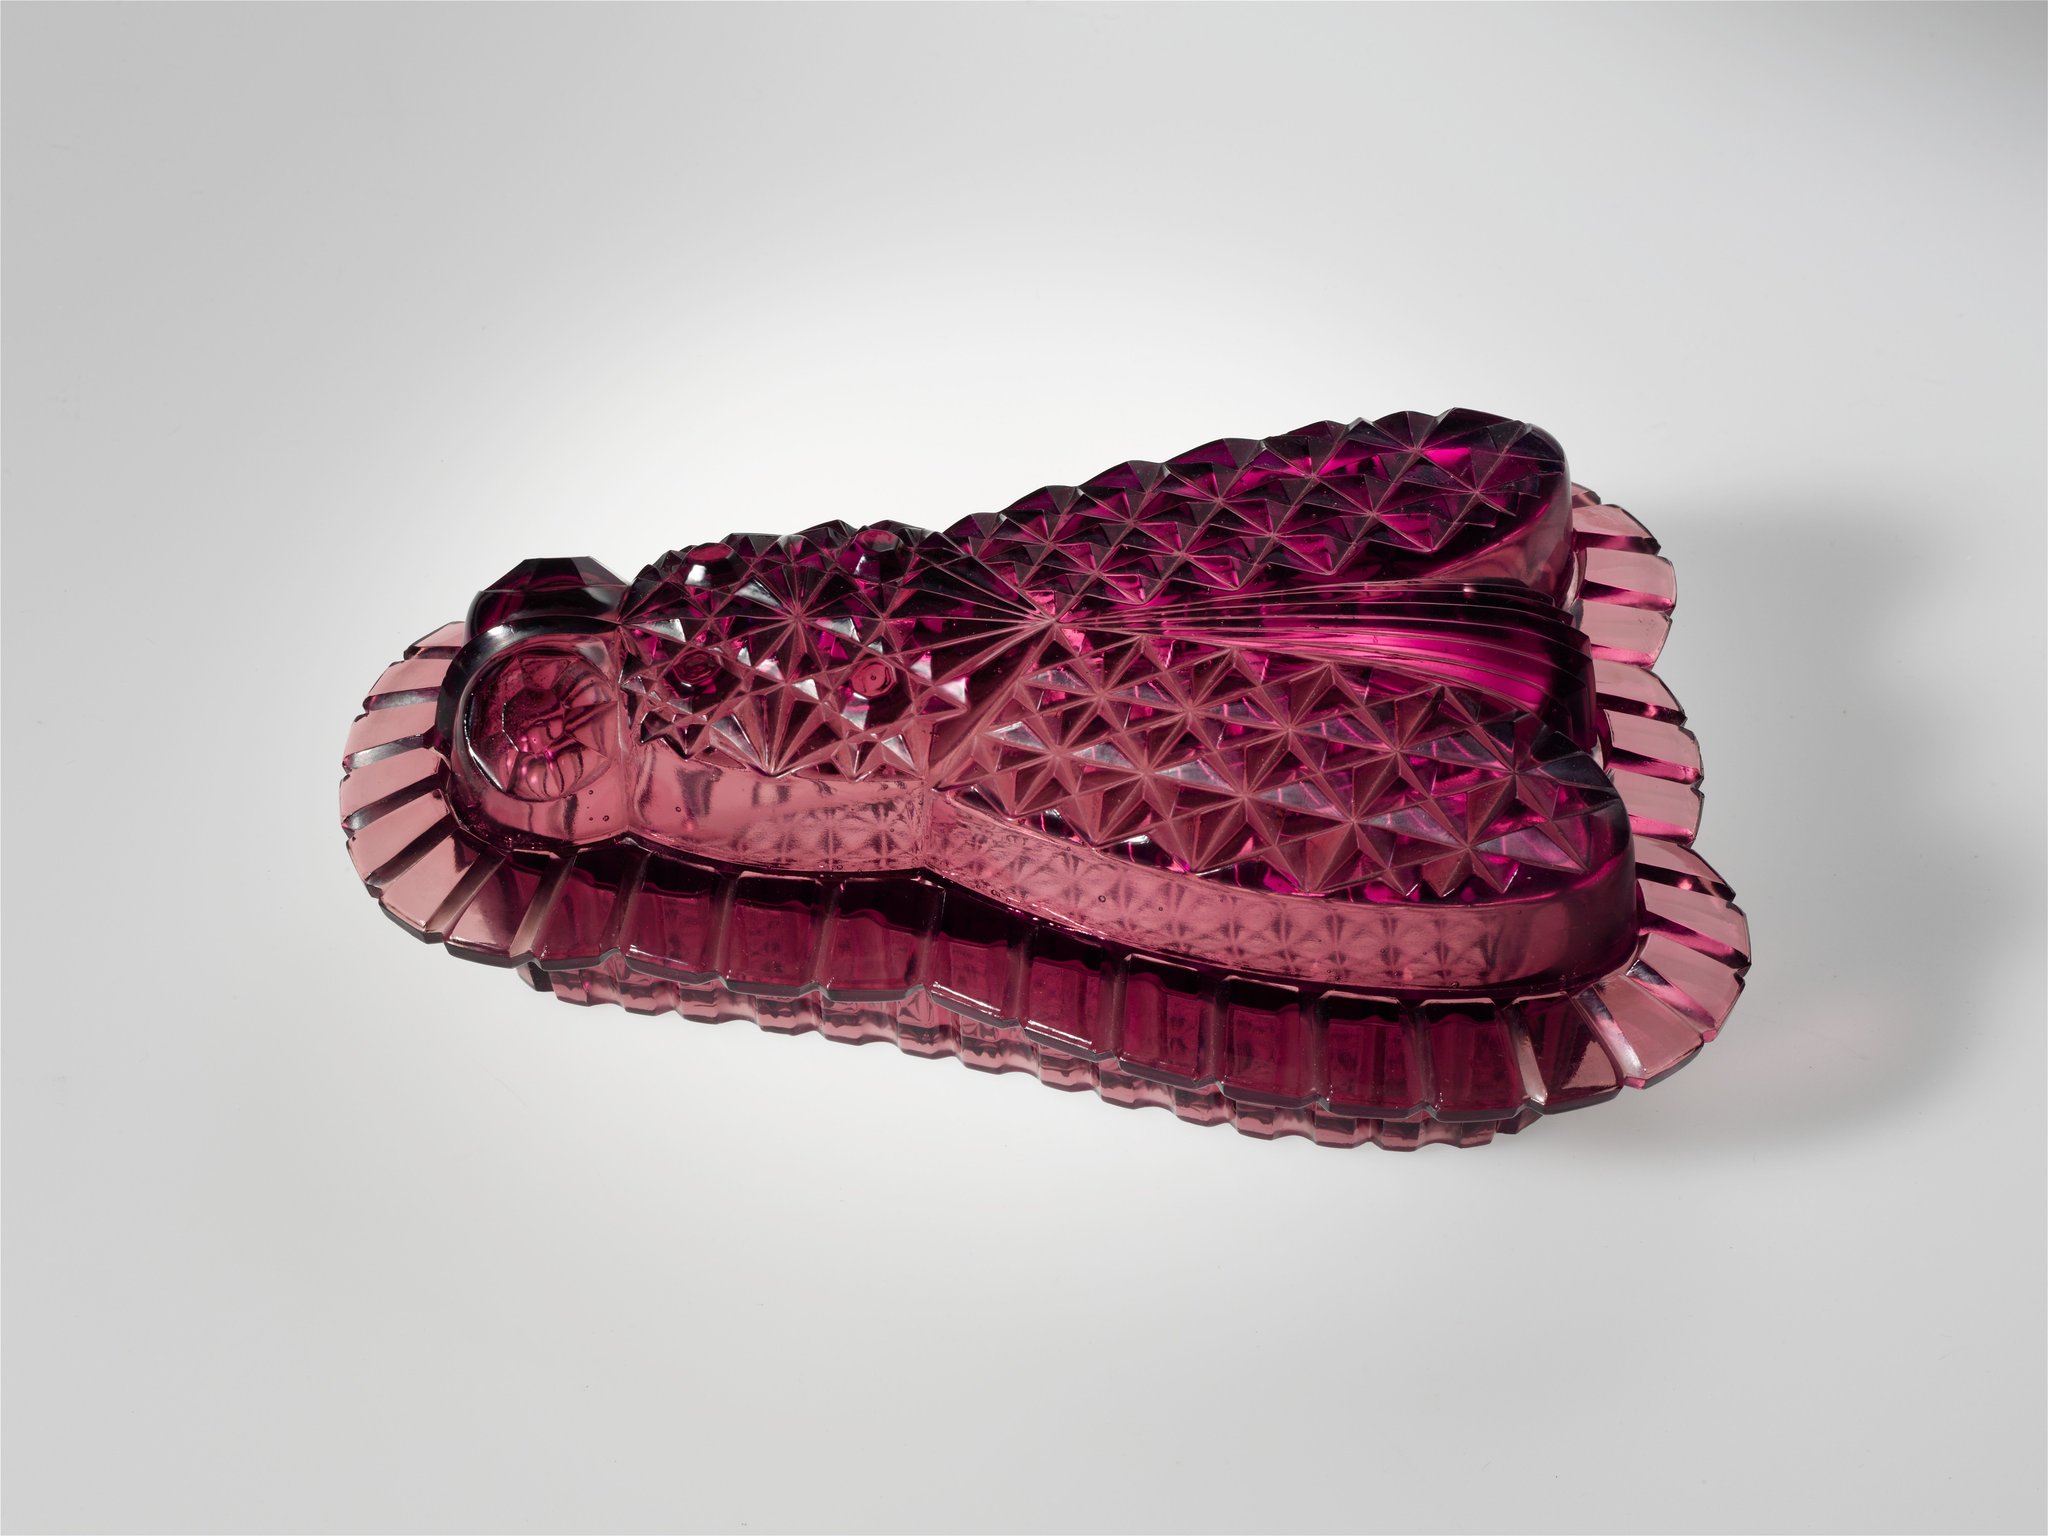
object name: dish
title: Covered Figural Dish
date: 1880-1900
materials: gemstone, glass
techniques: pressed